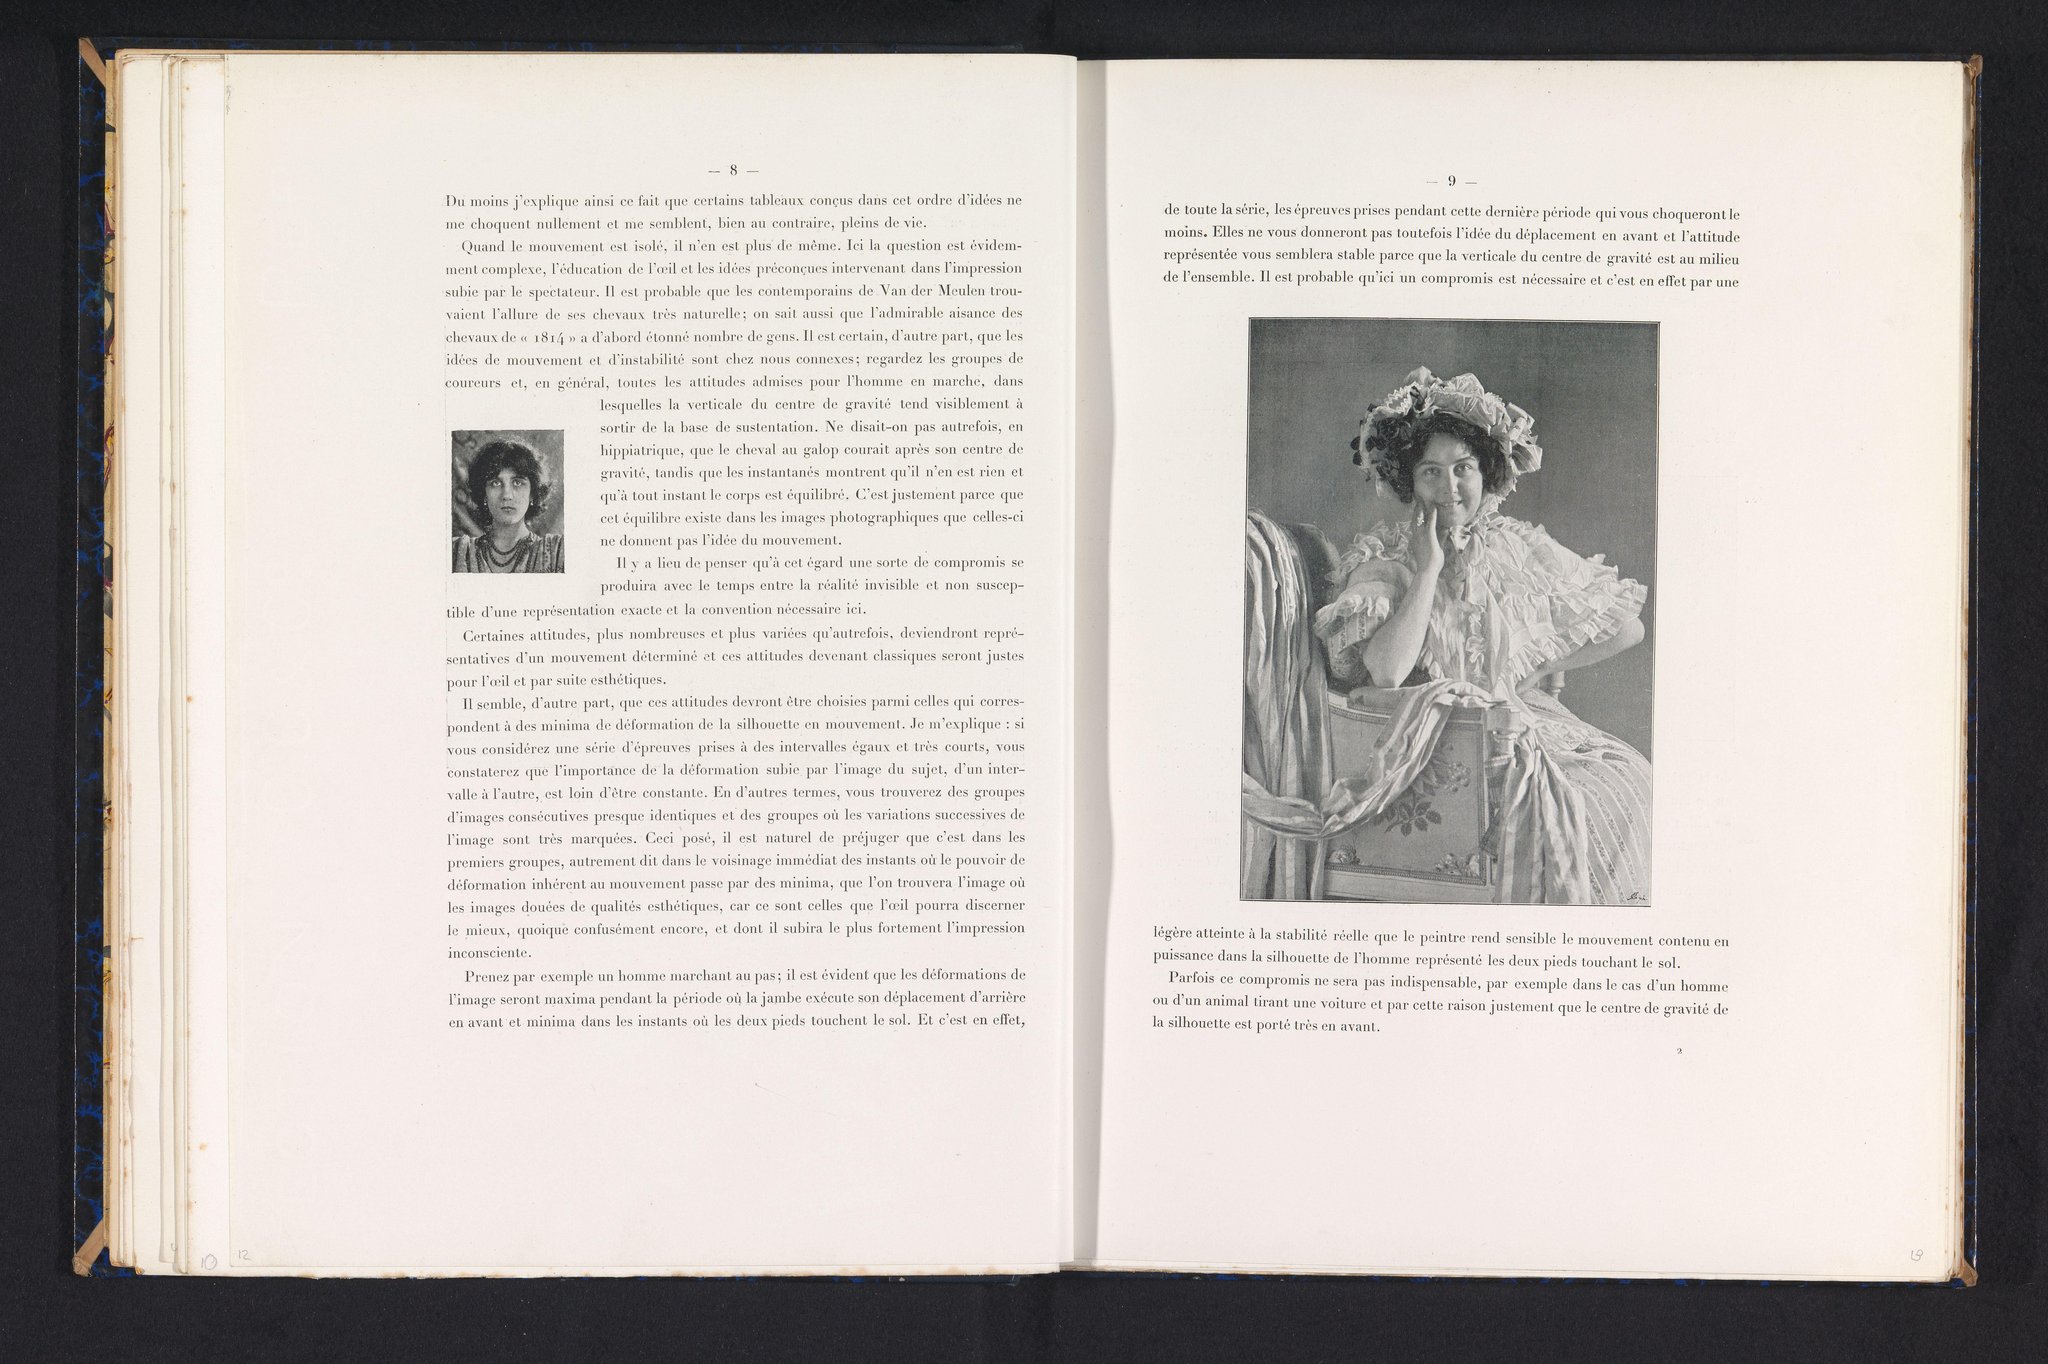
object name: photomechanical print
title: Portret van een onbekende vrouw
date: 1886-1896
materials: paper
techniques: autotype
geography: france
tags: anonymous historical person portrayed - bb - woman